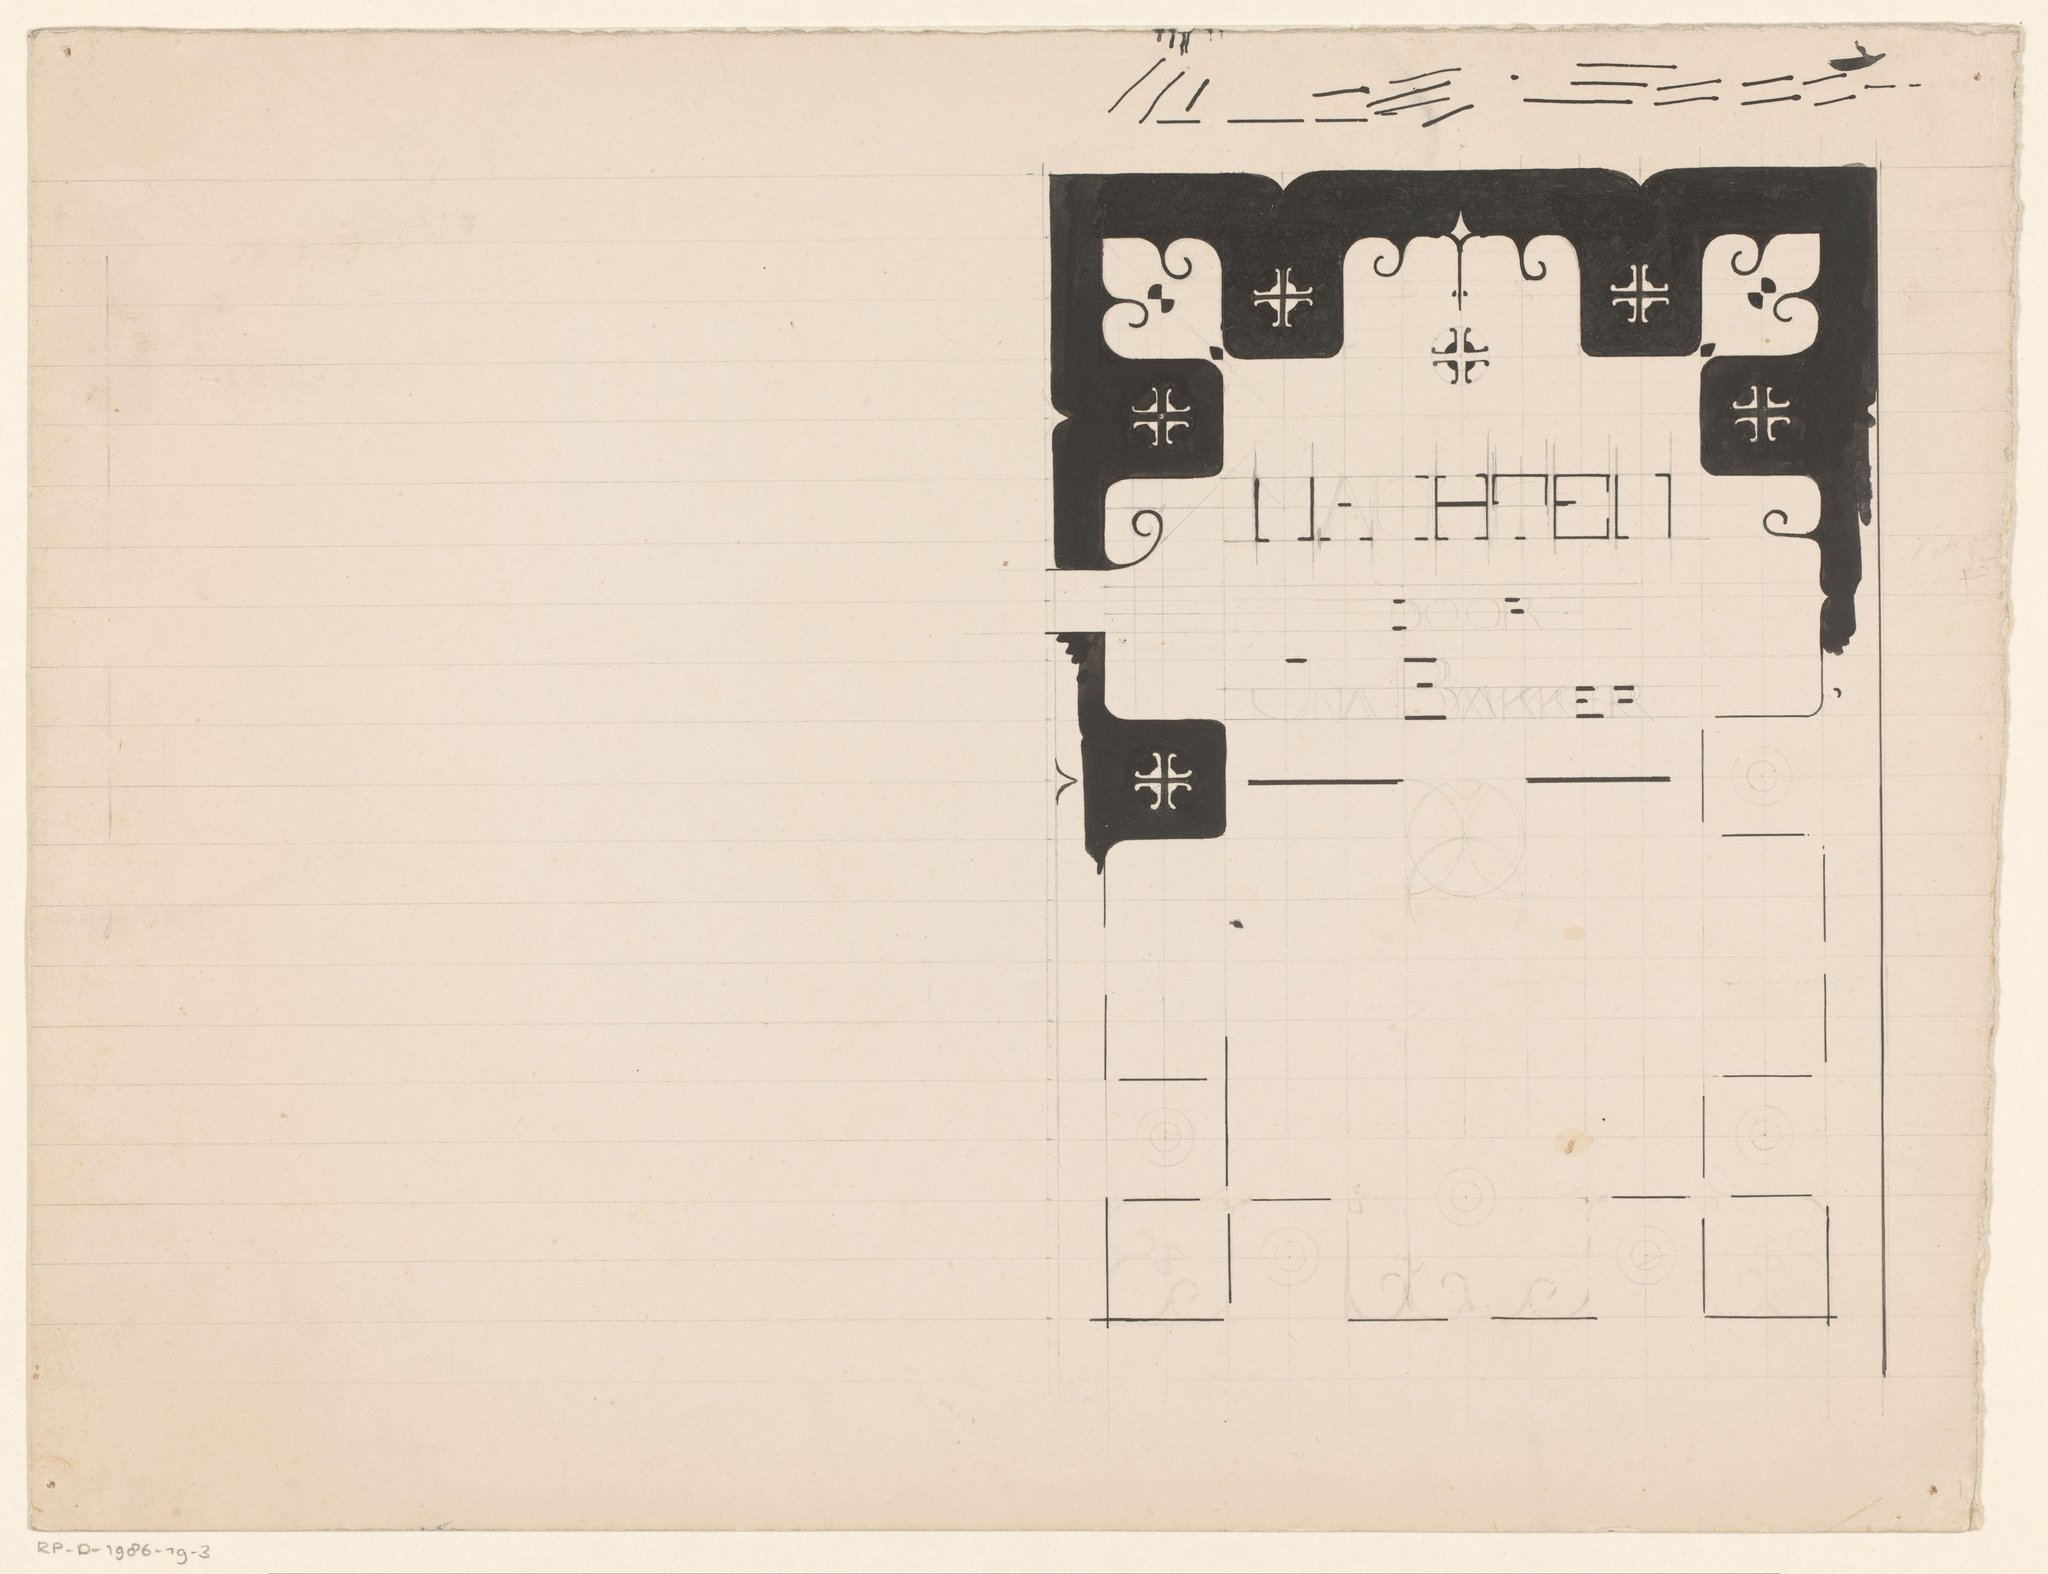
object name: drawing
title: Bandontwerp voor: Ina Boudier-Bakker, Machten, 1902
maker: reinier willem petrus de vries (1874-1953)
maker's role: draughtsman, print maker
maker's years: 1874-1953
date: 1902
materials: ink, paper, pencil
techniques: brush, pen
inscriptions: collector's mark: ‘R:MVS.’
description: Bandontwerp voor: Boedier-Bakker, Ina. Machten. Amsterdam: Van Kampen, 1902.